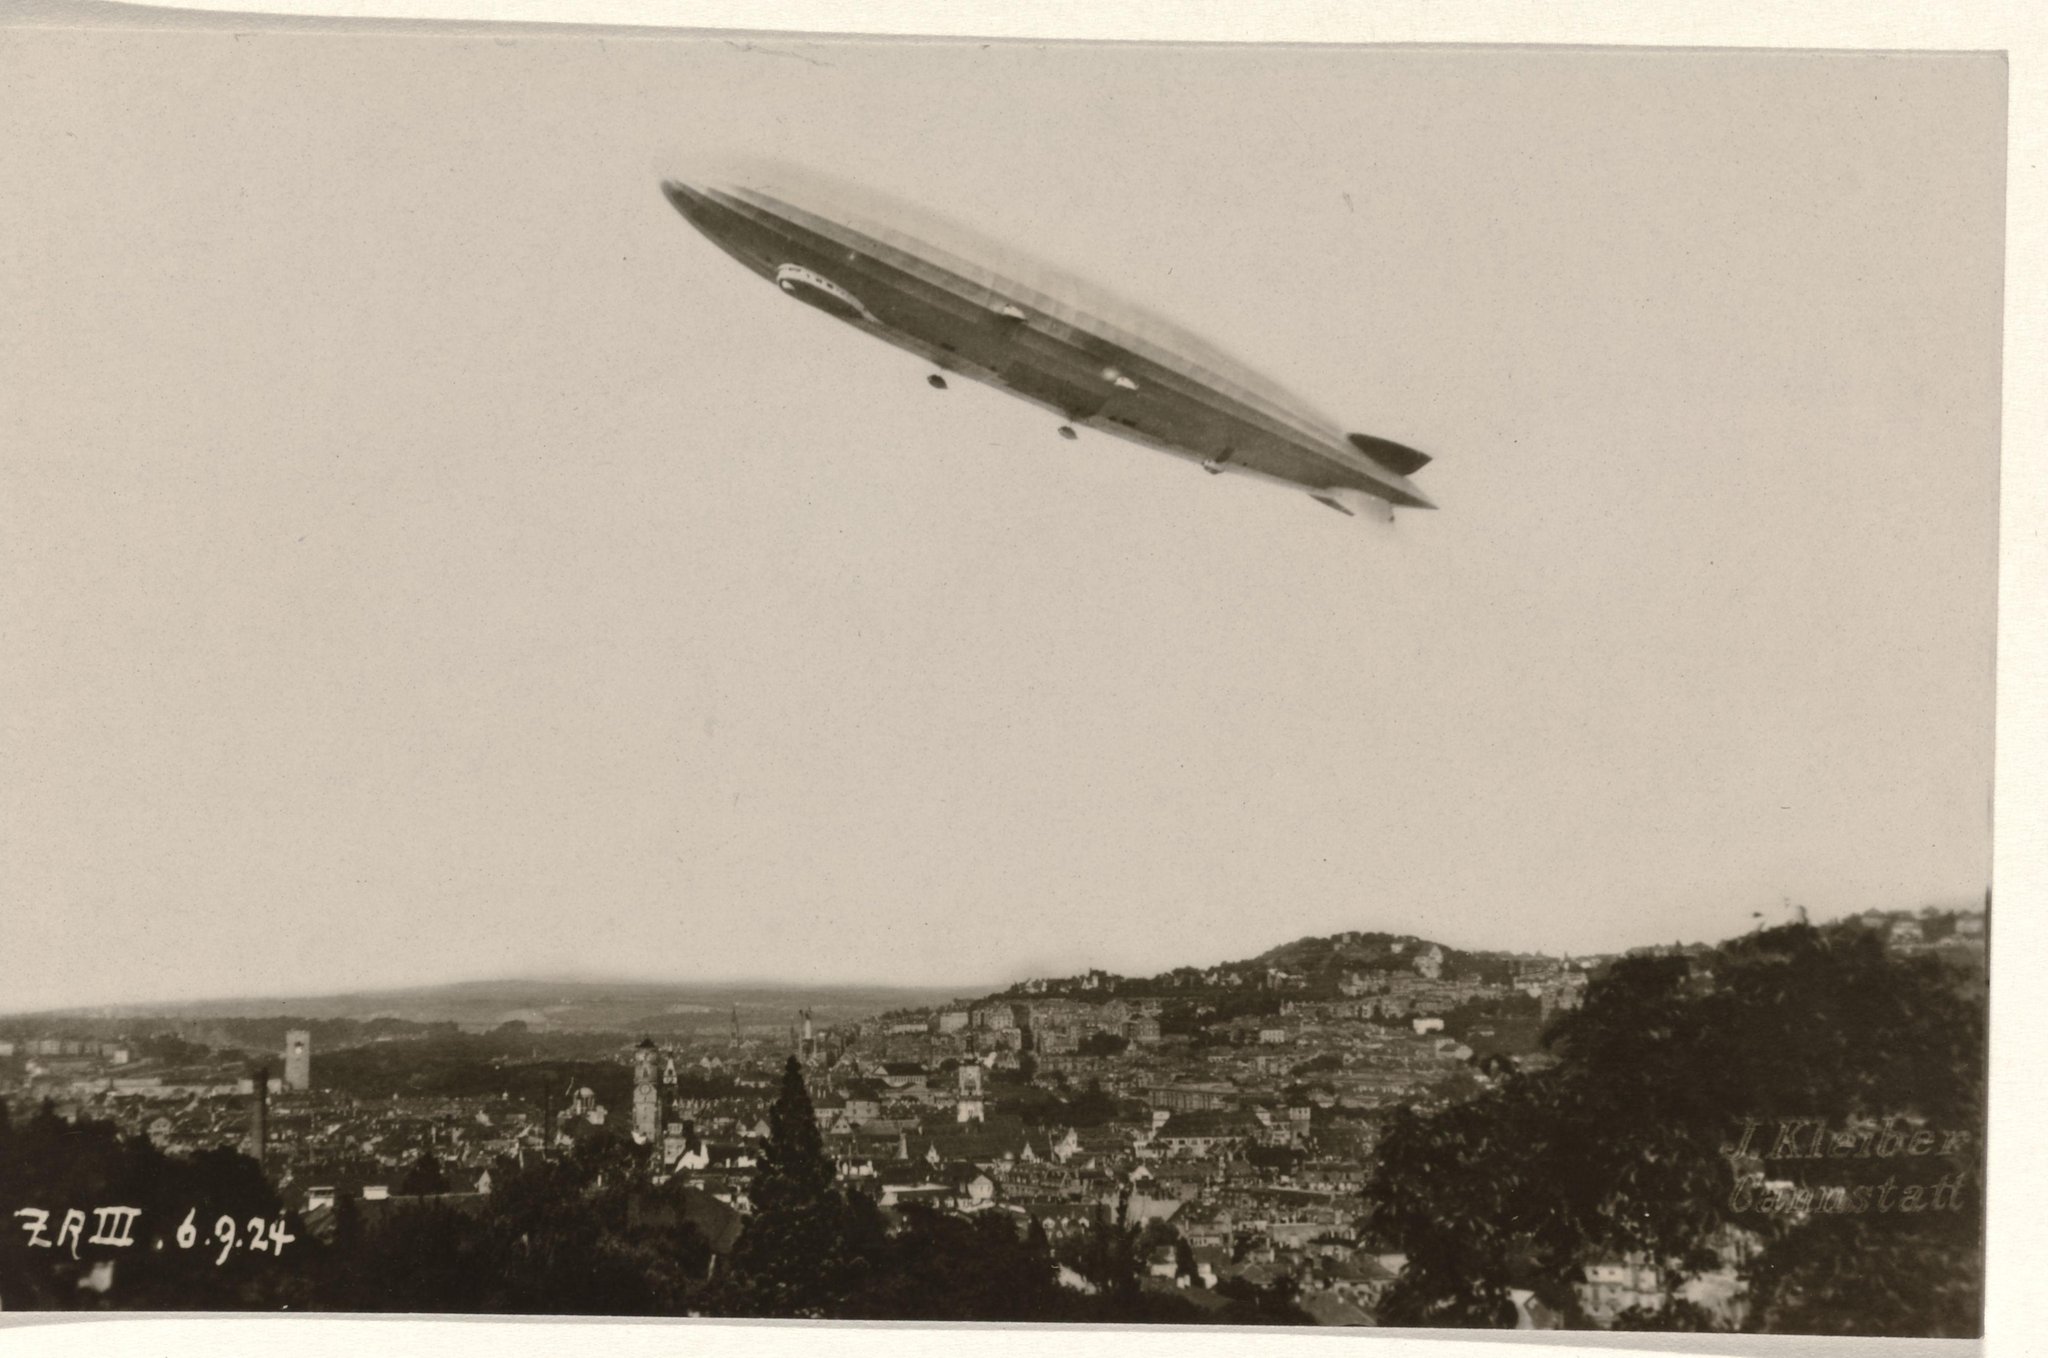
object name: photograph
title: Vliegende zeppelin boven een stad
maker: Anonymous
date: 1924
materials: photographic support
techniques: gelatin silver print